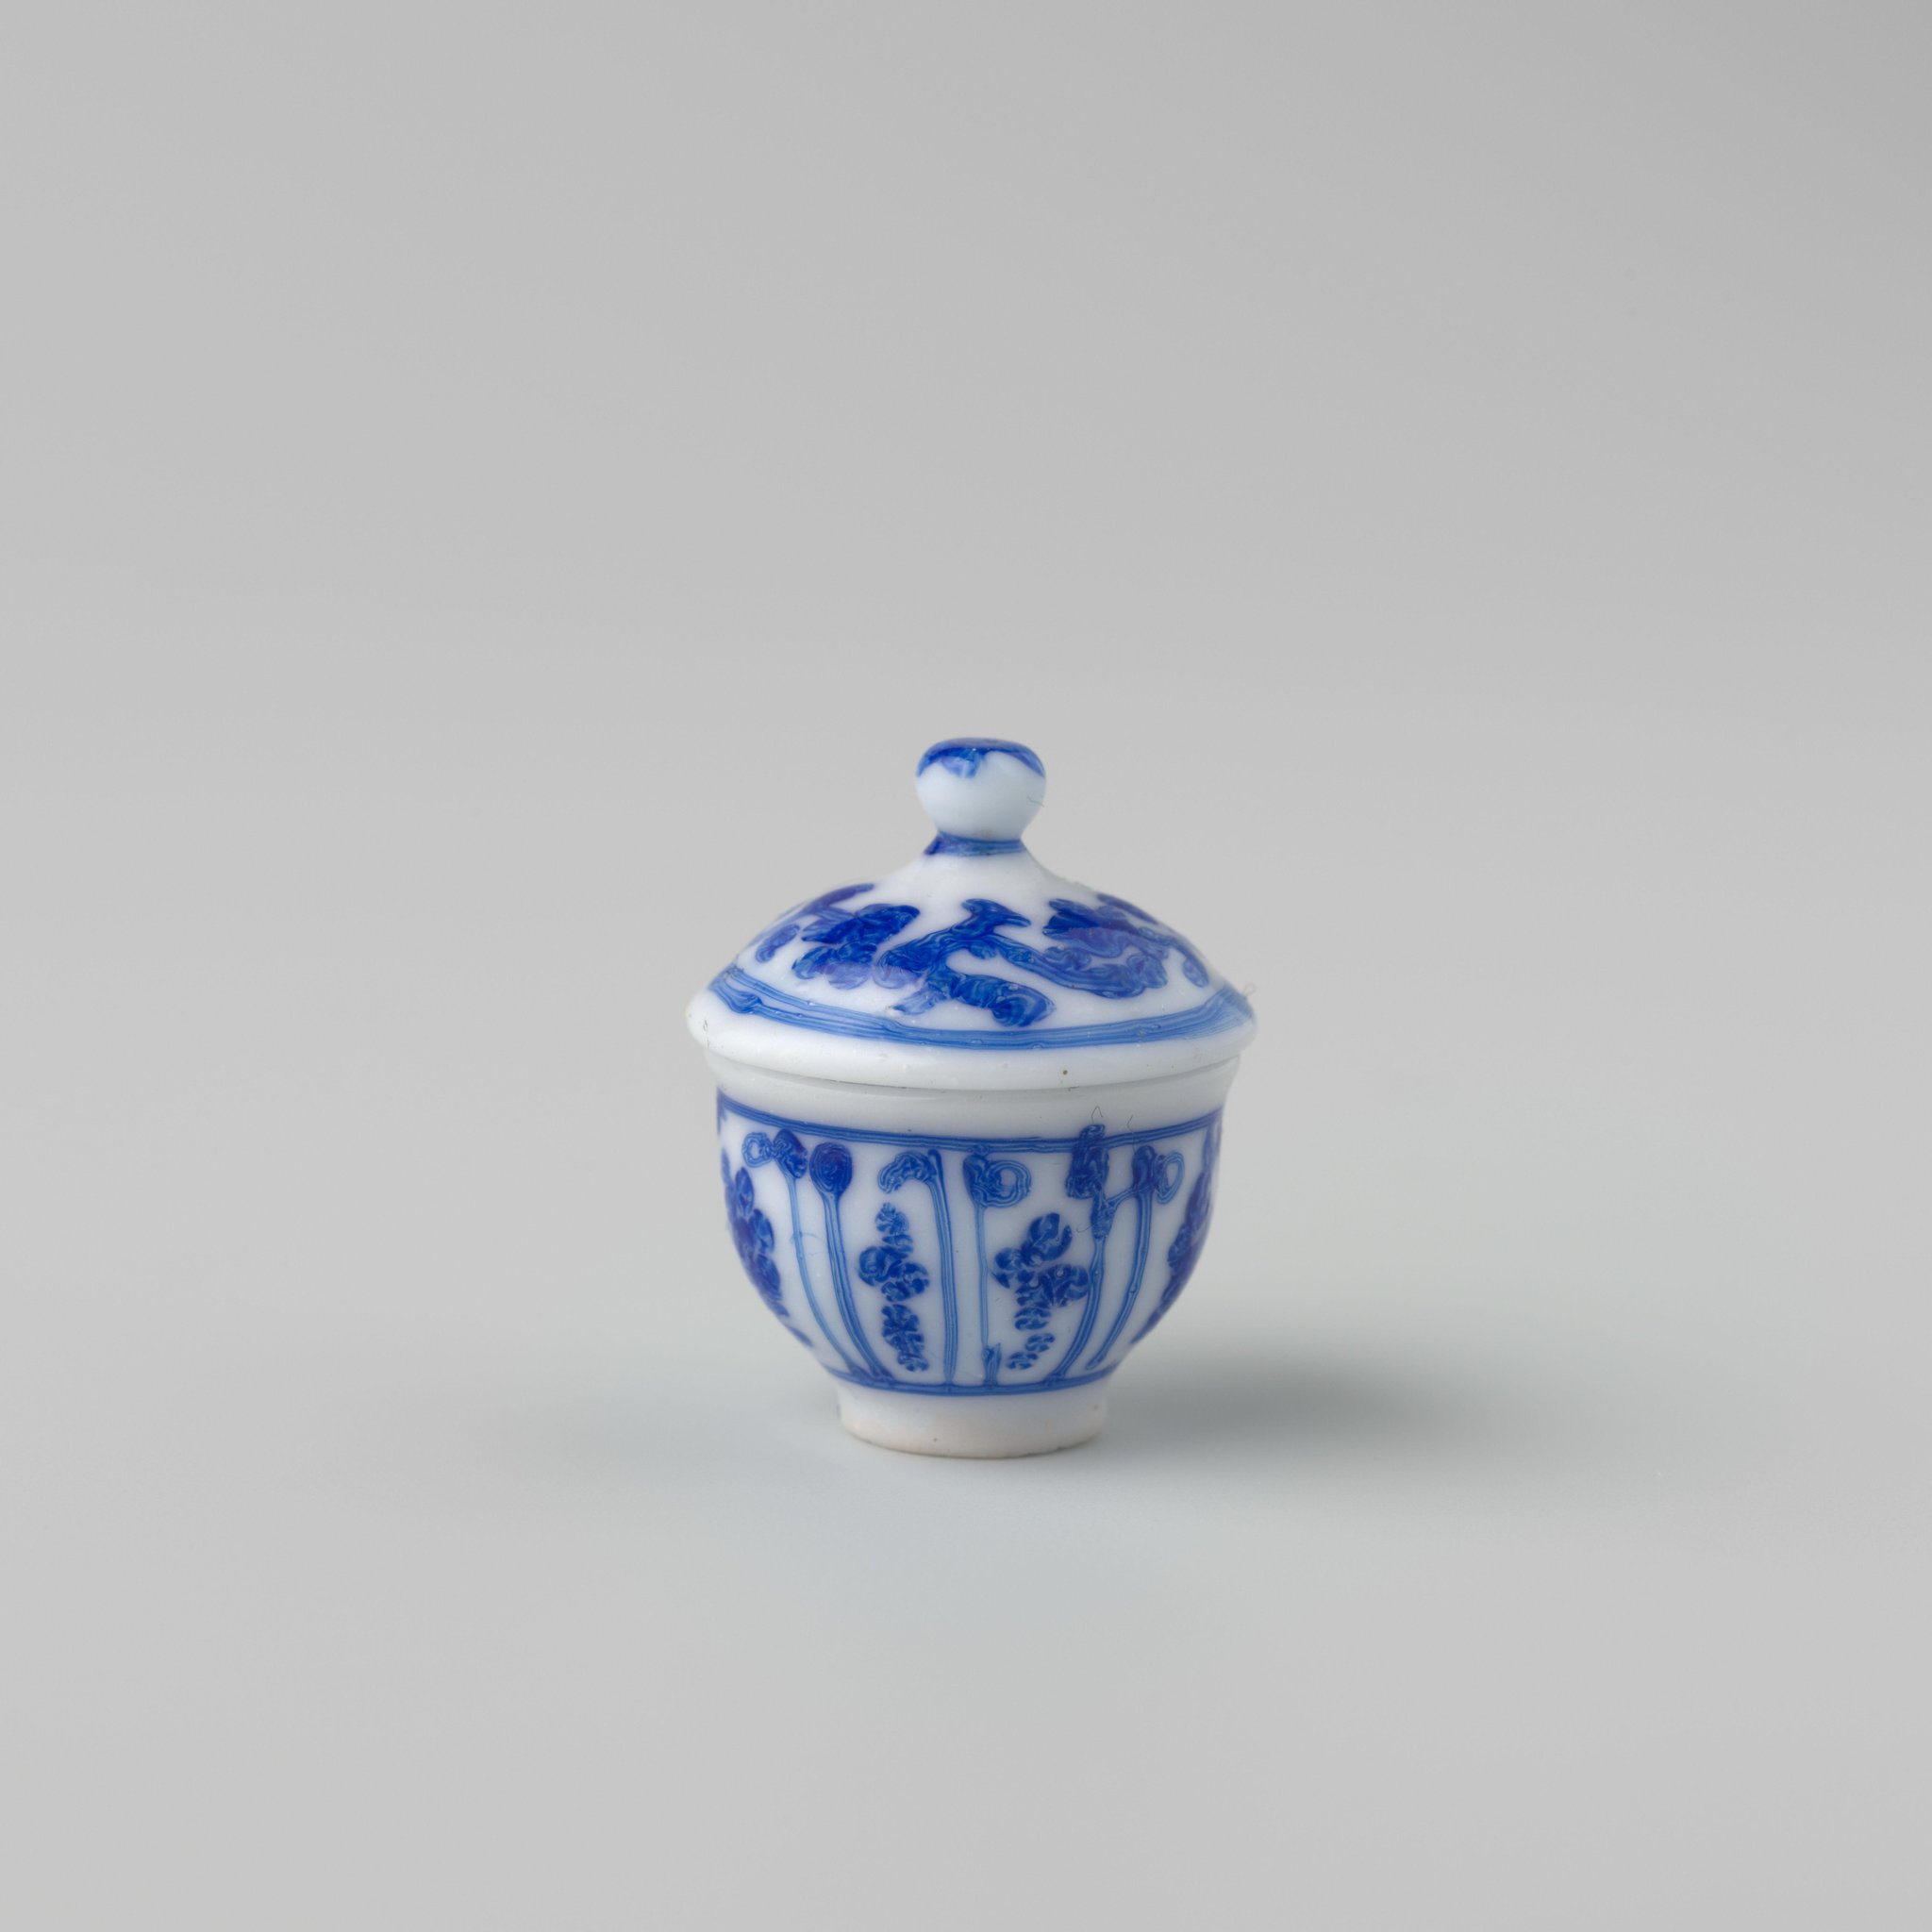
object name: bowl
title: Kom met deksel van melkglas met blauwe emailverf beschildering, imitatie Chinees porselein; kelkvormig kom met bloemmotieven tussen verticale lijnen, bolle deksel met knop.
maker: Anonymous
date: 1675-1710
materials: glass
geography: amsterdam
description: Kom met deksel van melkglas met blauwe emailverf beschildering, imitatie Chinees blauw porselein; kelkvormige kom met decoratie van bloemmotieven tussen verticale lijnen, waarop een bolle deksel met knop, versierd met doorlopende bloemrank.